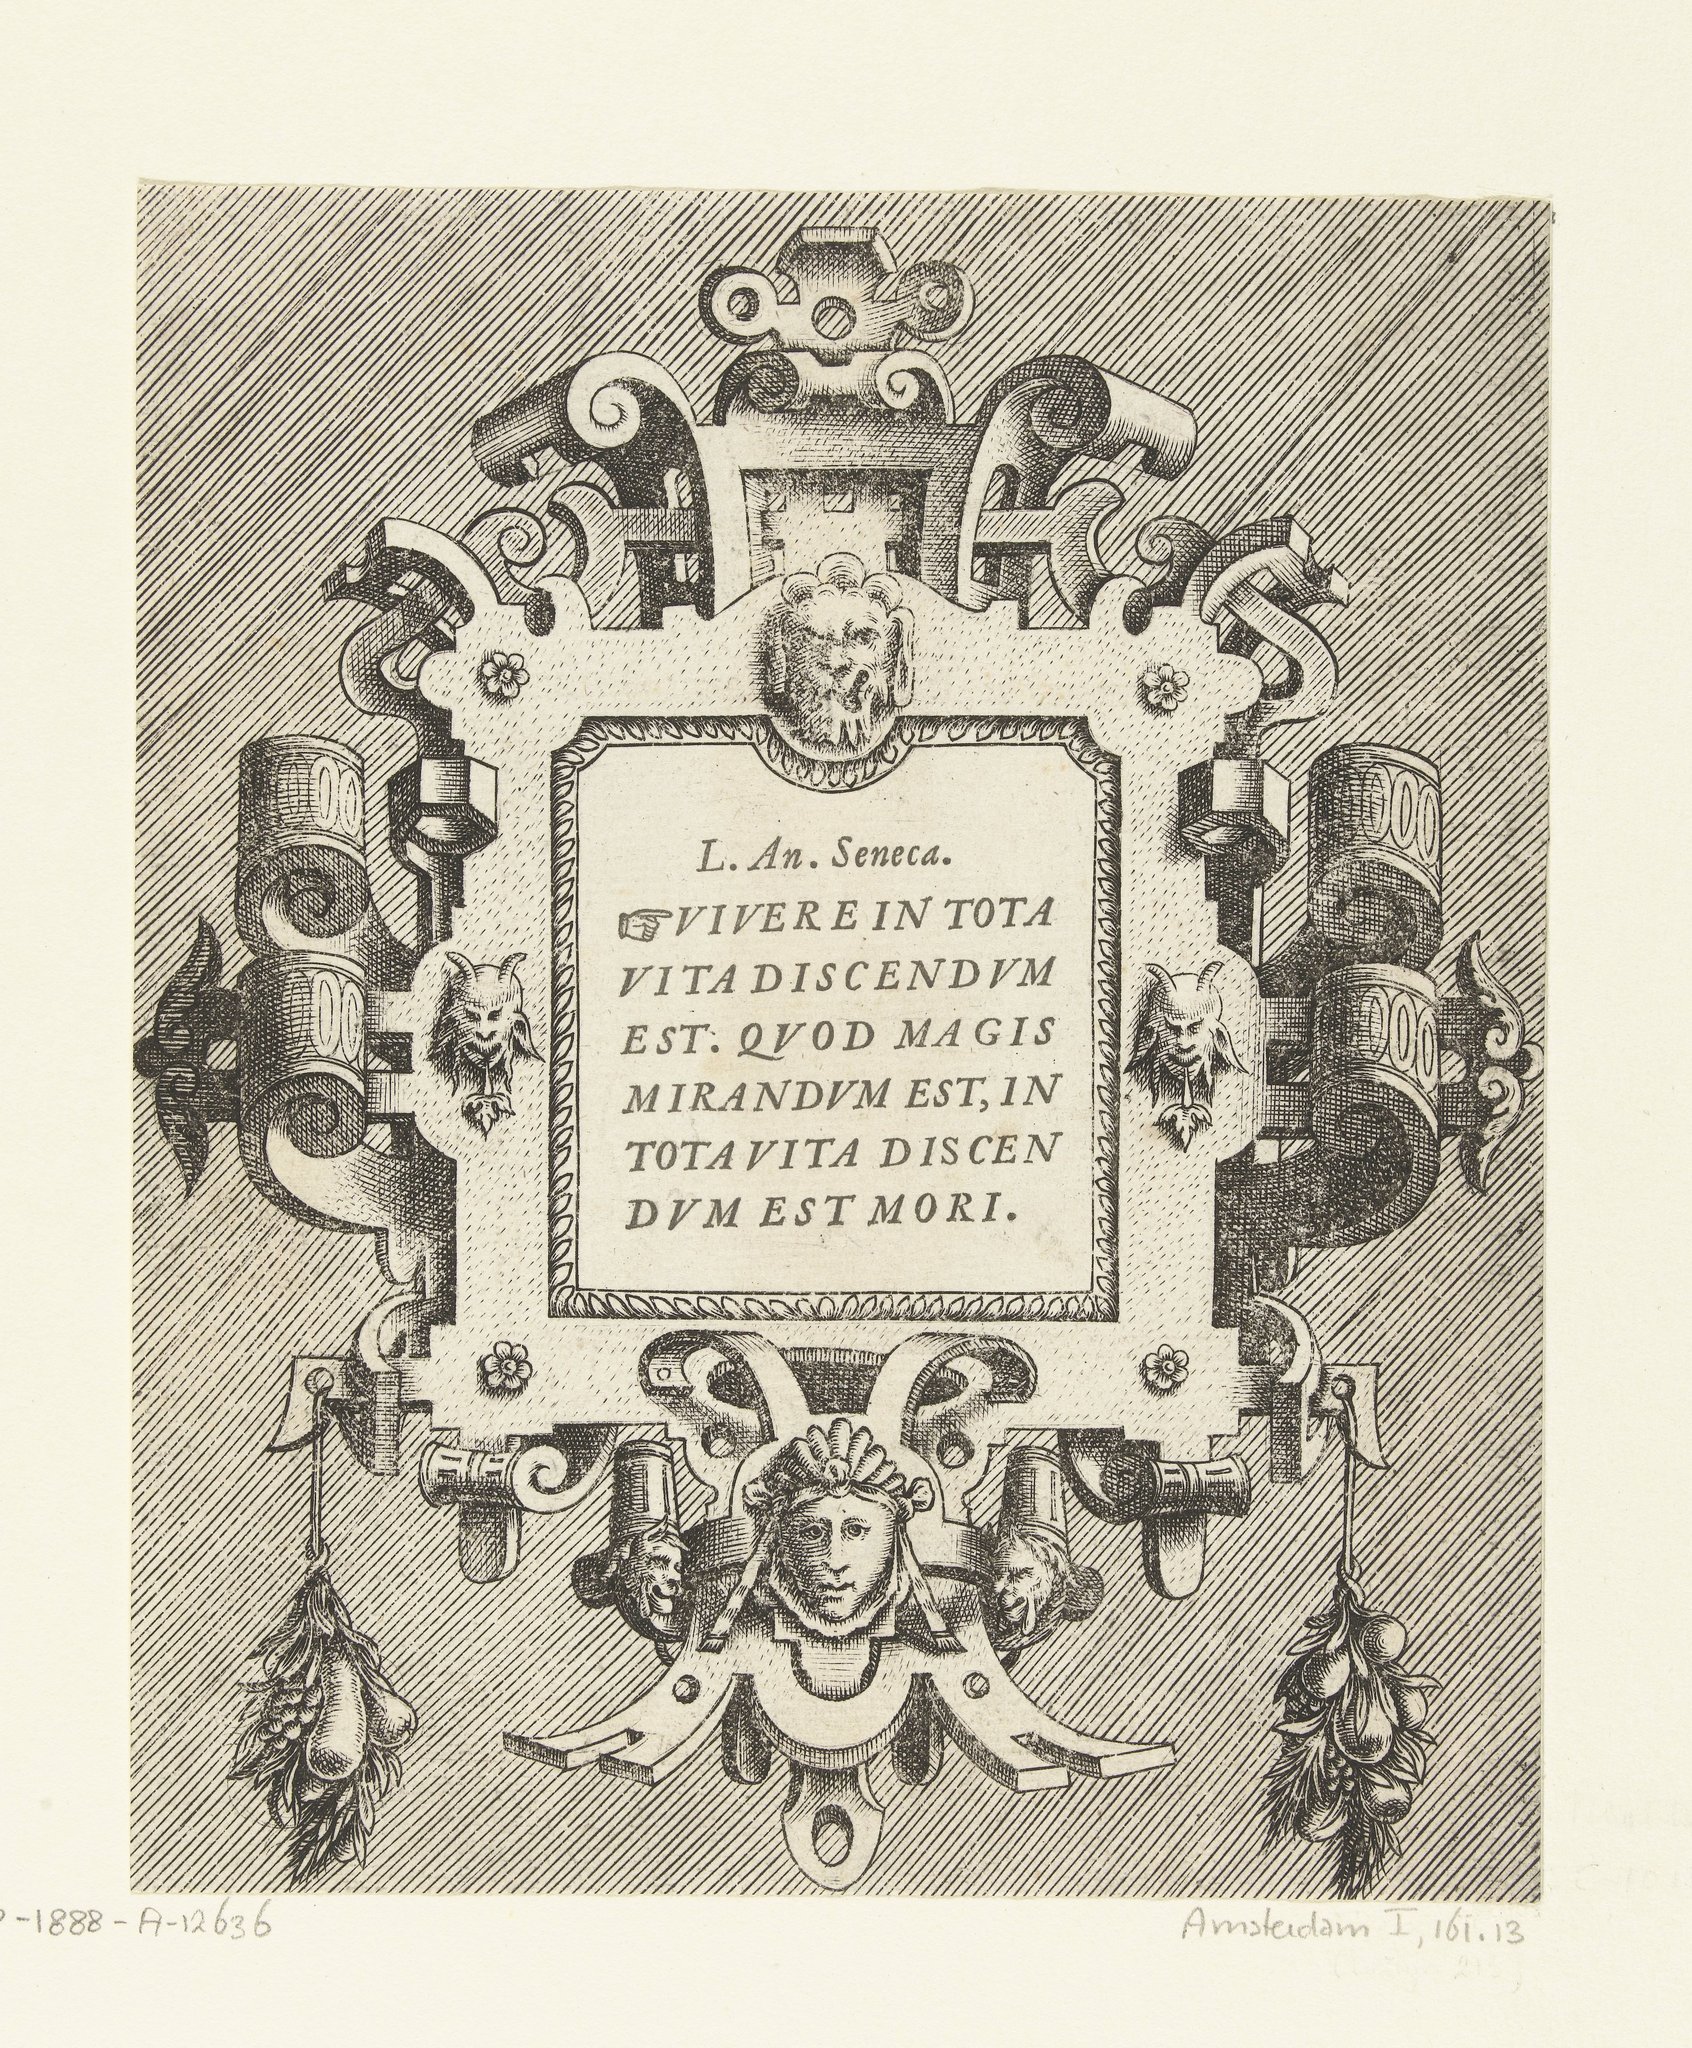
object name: ornament print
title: Cartouche met een citaat van Seneca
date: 1555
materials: paper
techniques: etching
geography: netherlands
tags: fruits and vegetables ~ ornament, ornament ~ cartouche, mask, mascaron ~ ornament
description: Citaat: VIVERE IN TOTA VITA DISCENDVM EST....in cartouche. Op de cartouche zitten zes mascarons. Linksonder en rechtsonder hangt een fruittros. Gearceerde achtergrond. Uit serie van titelblad en 12 bladen met cartouches met citaten van klassieke schrijvers in een omlijsting van rolwerk met grotesken, mascarons en guirlandes.